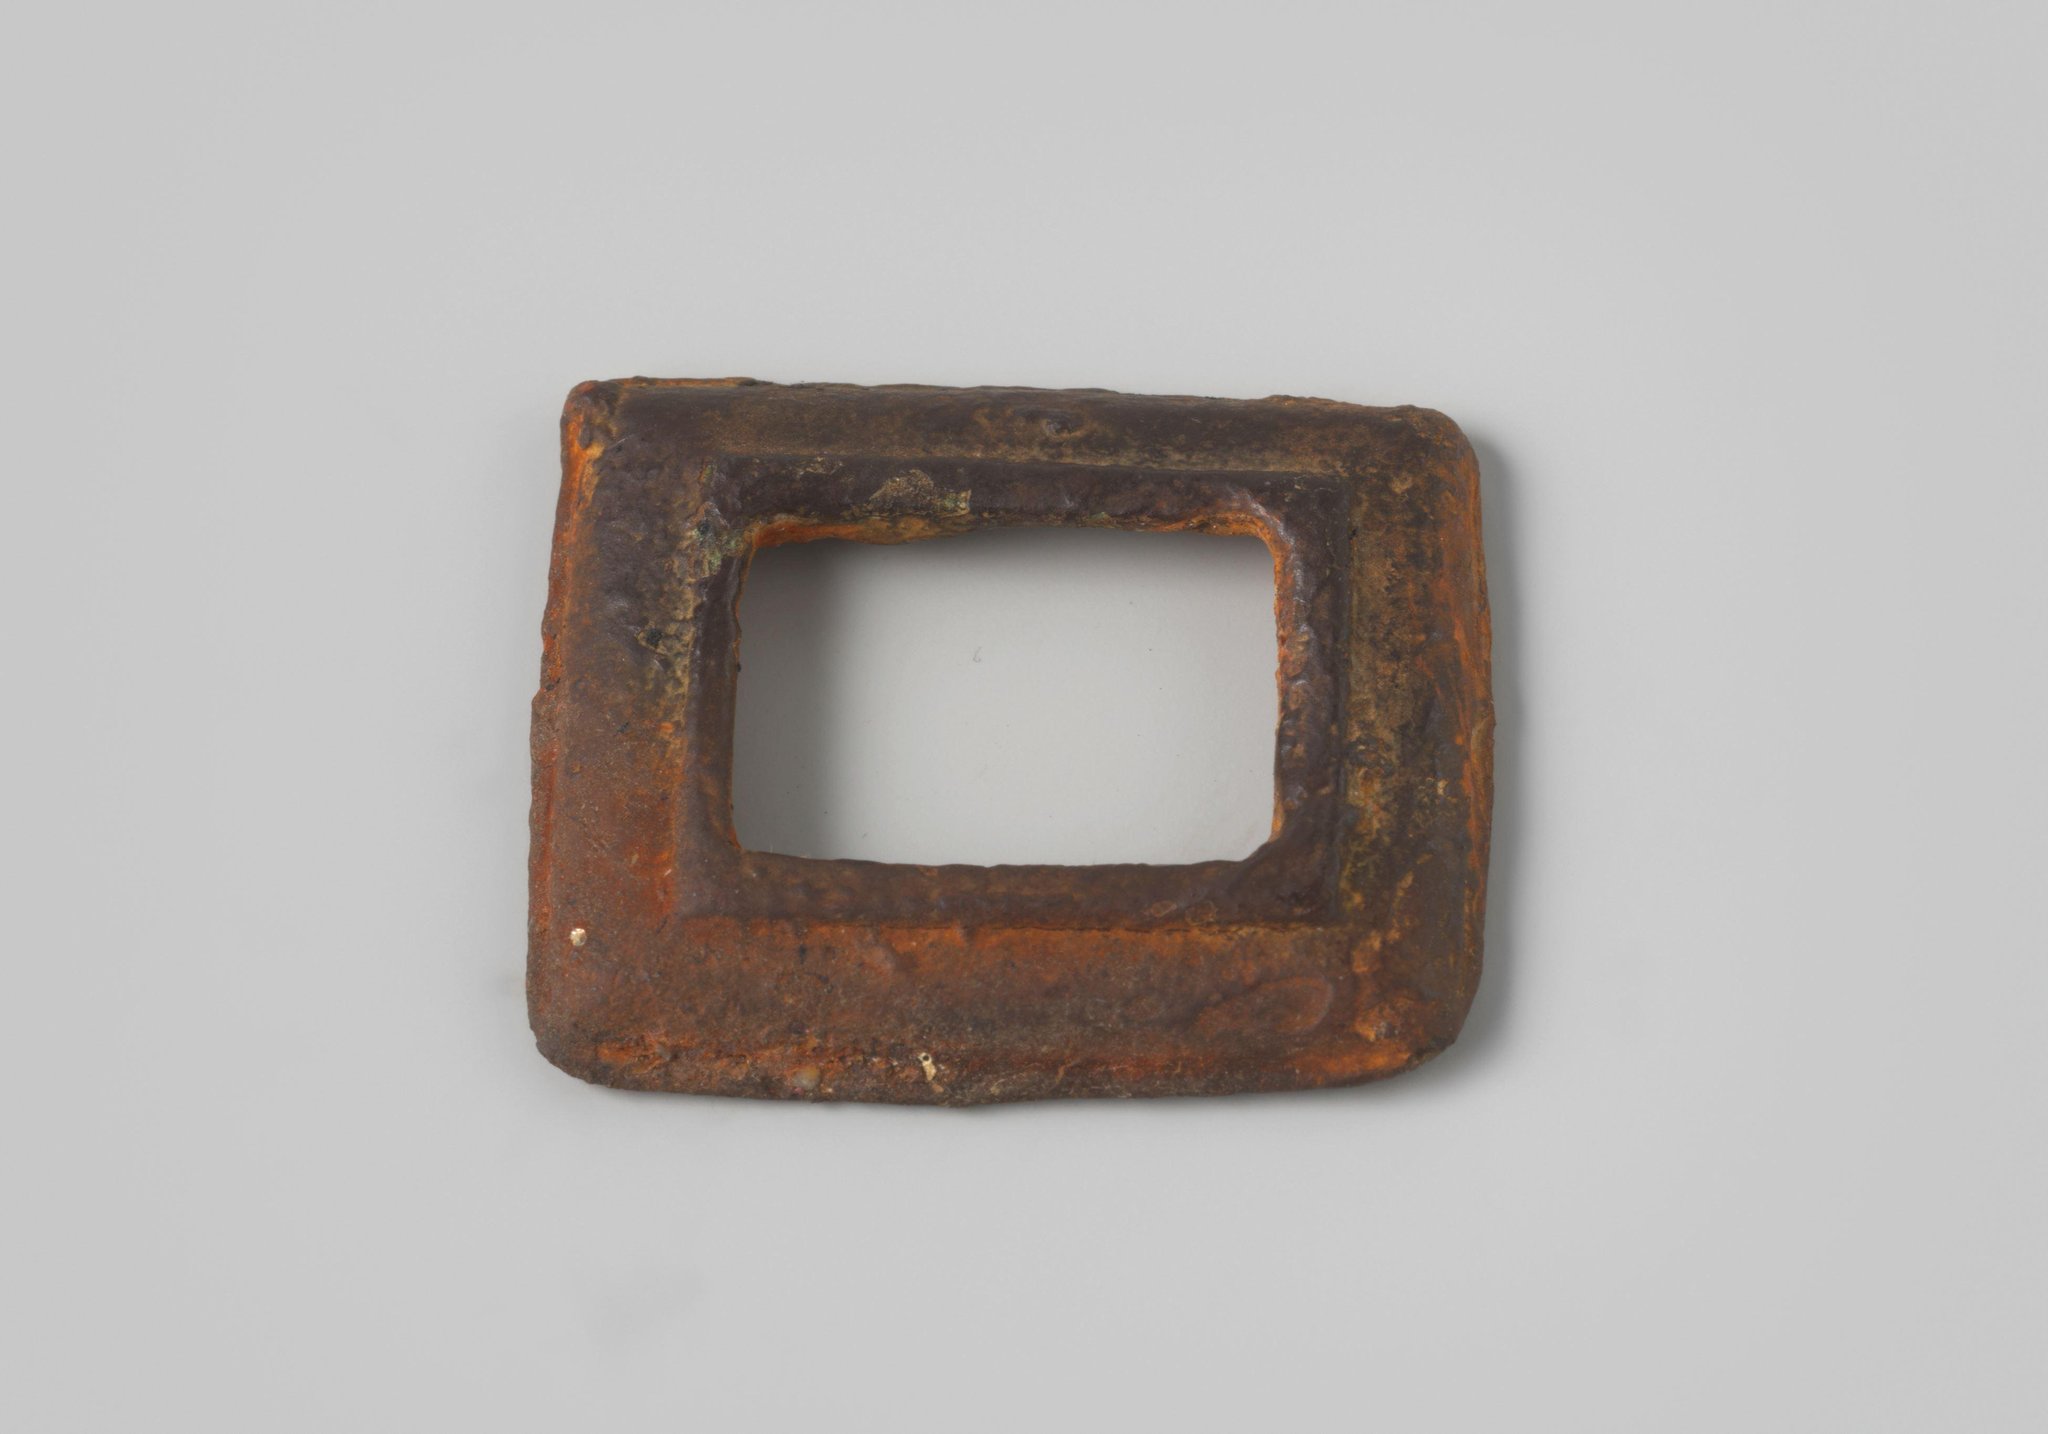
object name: sluitring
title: Sluitring van een gevest uit het wrak van de Oost-Indiëvaarder Hollandia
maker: Anonymous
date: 1700-1743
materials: copper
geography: netherlands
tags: verenigde oostindische compagnie, hollandia (schip), annet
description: Hilt, washer rectangular, bevelled outer edge, rectangular central hole with stepped edge, concave underneath.